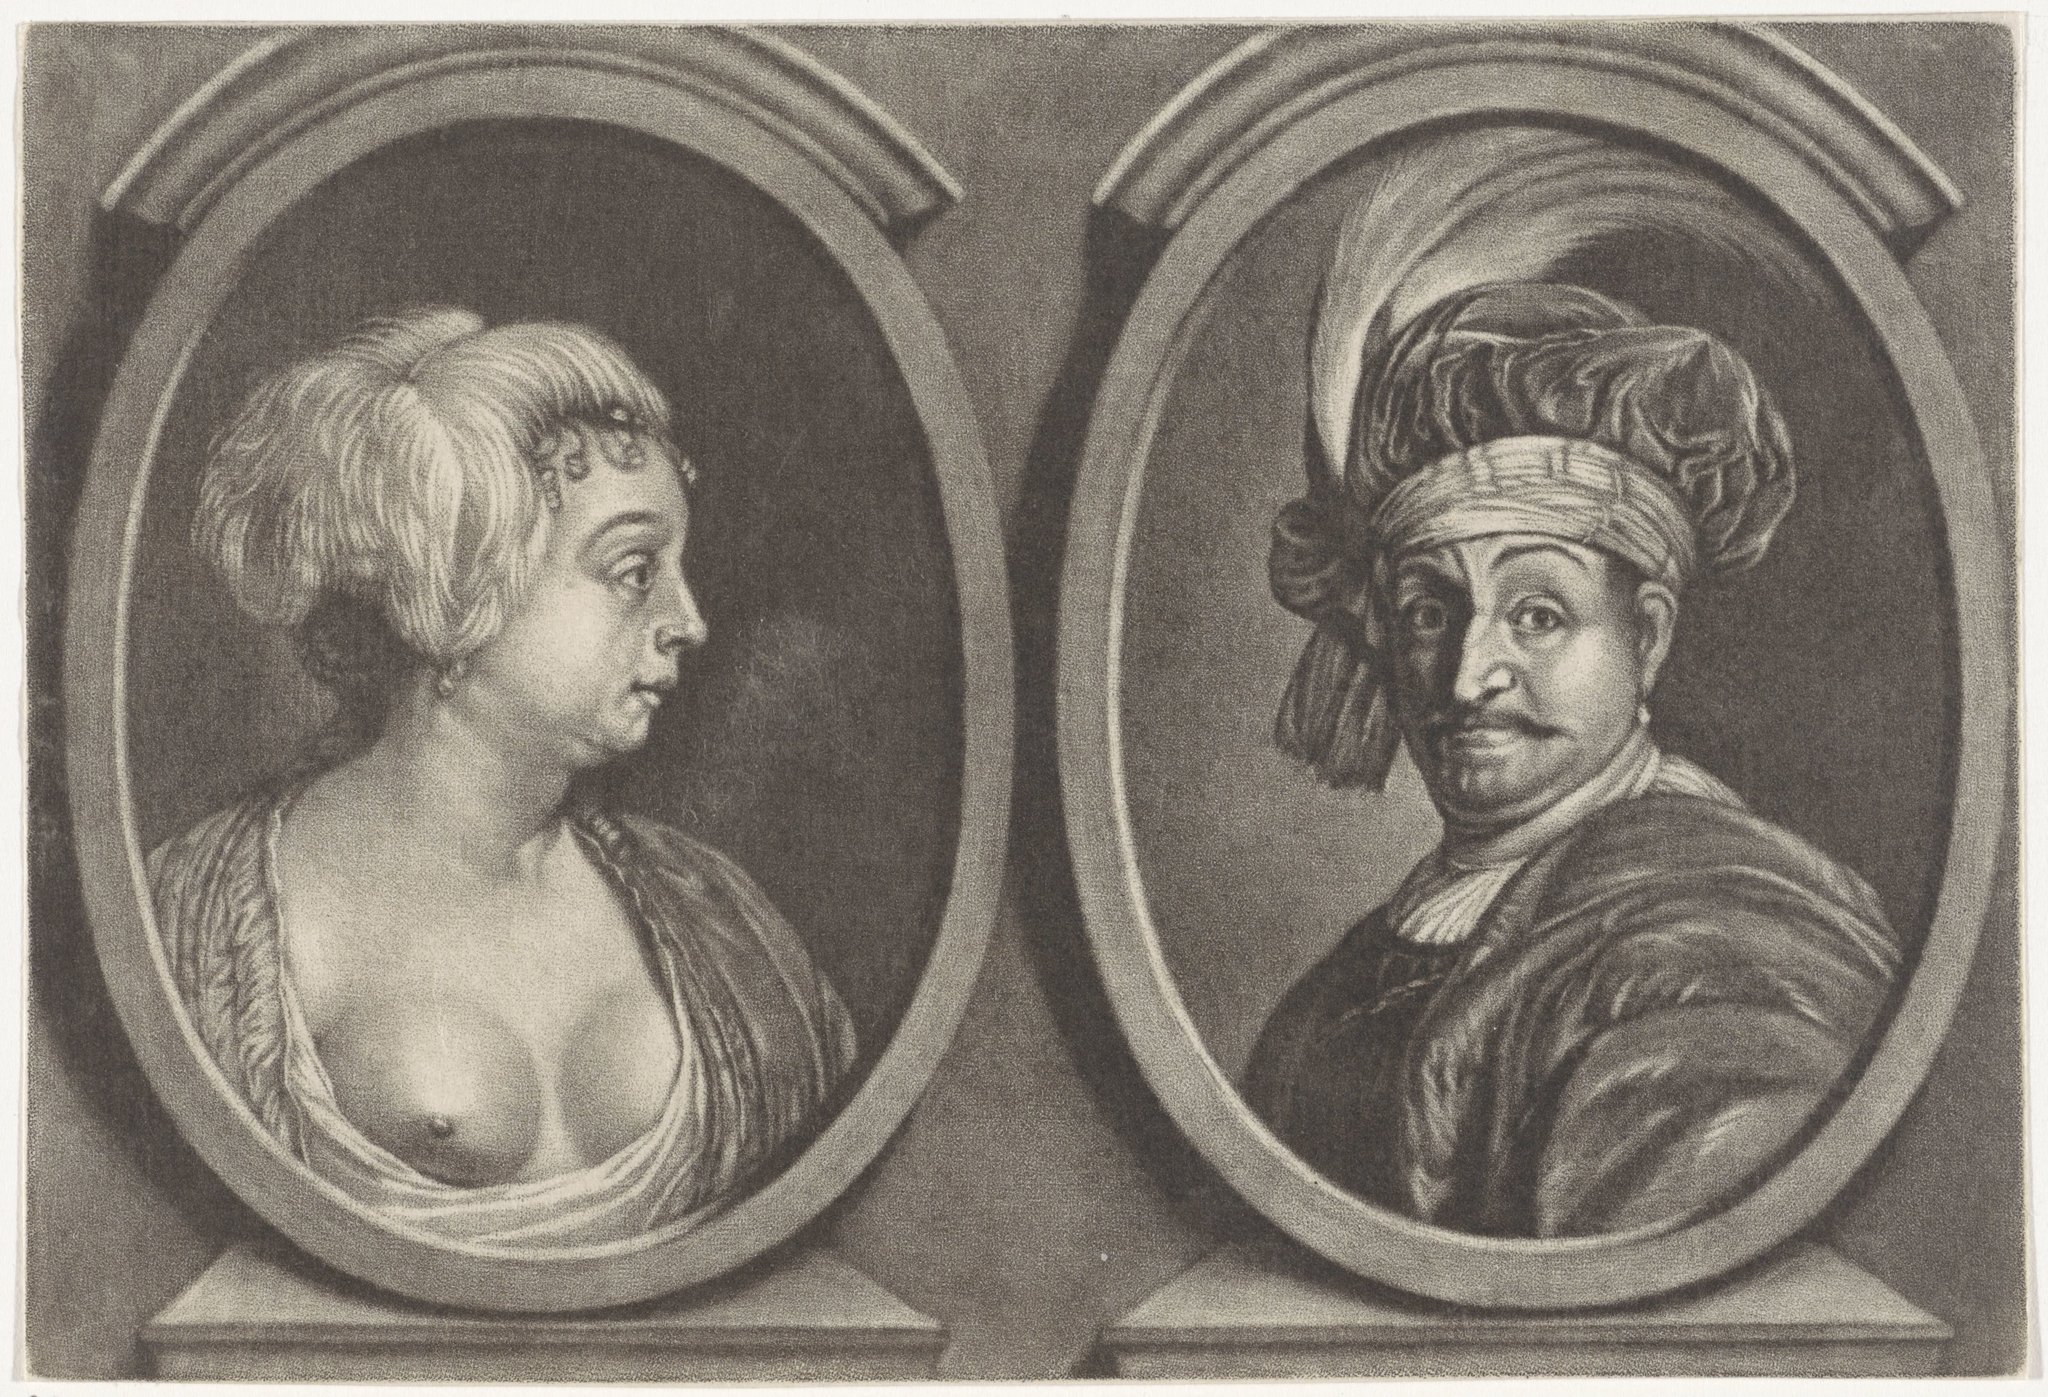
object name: print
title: Dubbelportret van een man en een vrouw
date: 1650-1800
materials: paper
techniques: mezzotint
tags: head-gear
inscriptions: collector's mark: Lugt 2760, collector's mark: Lugt 2228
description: Dubbelportret van een onbekende vrouw met een veer in het haar en een ontblote borst en een onbekende man met een gepluimde baret.